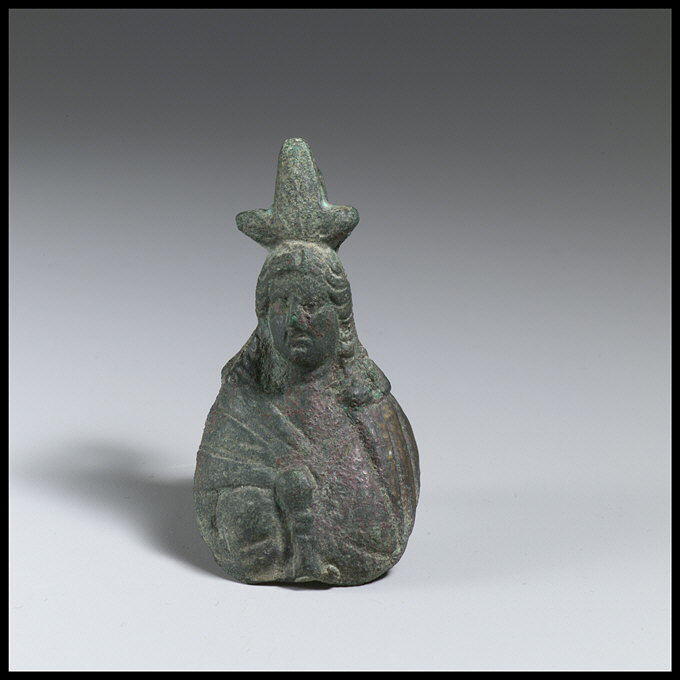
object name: weight, bust of isi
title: Bronze steelyard weight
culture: roman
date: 101-300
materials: bronze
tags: isis